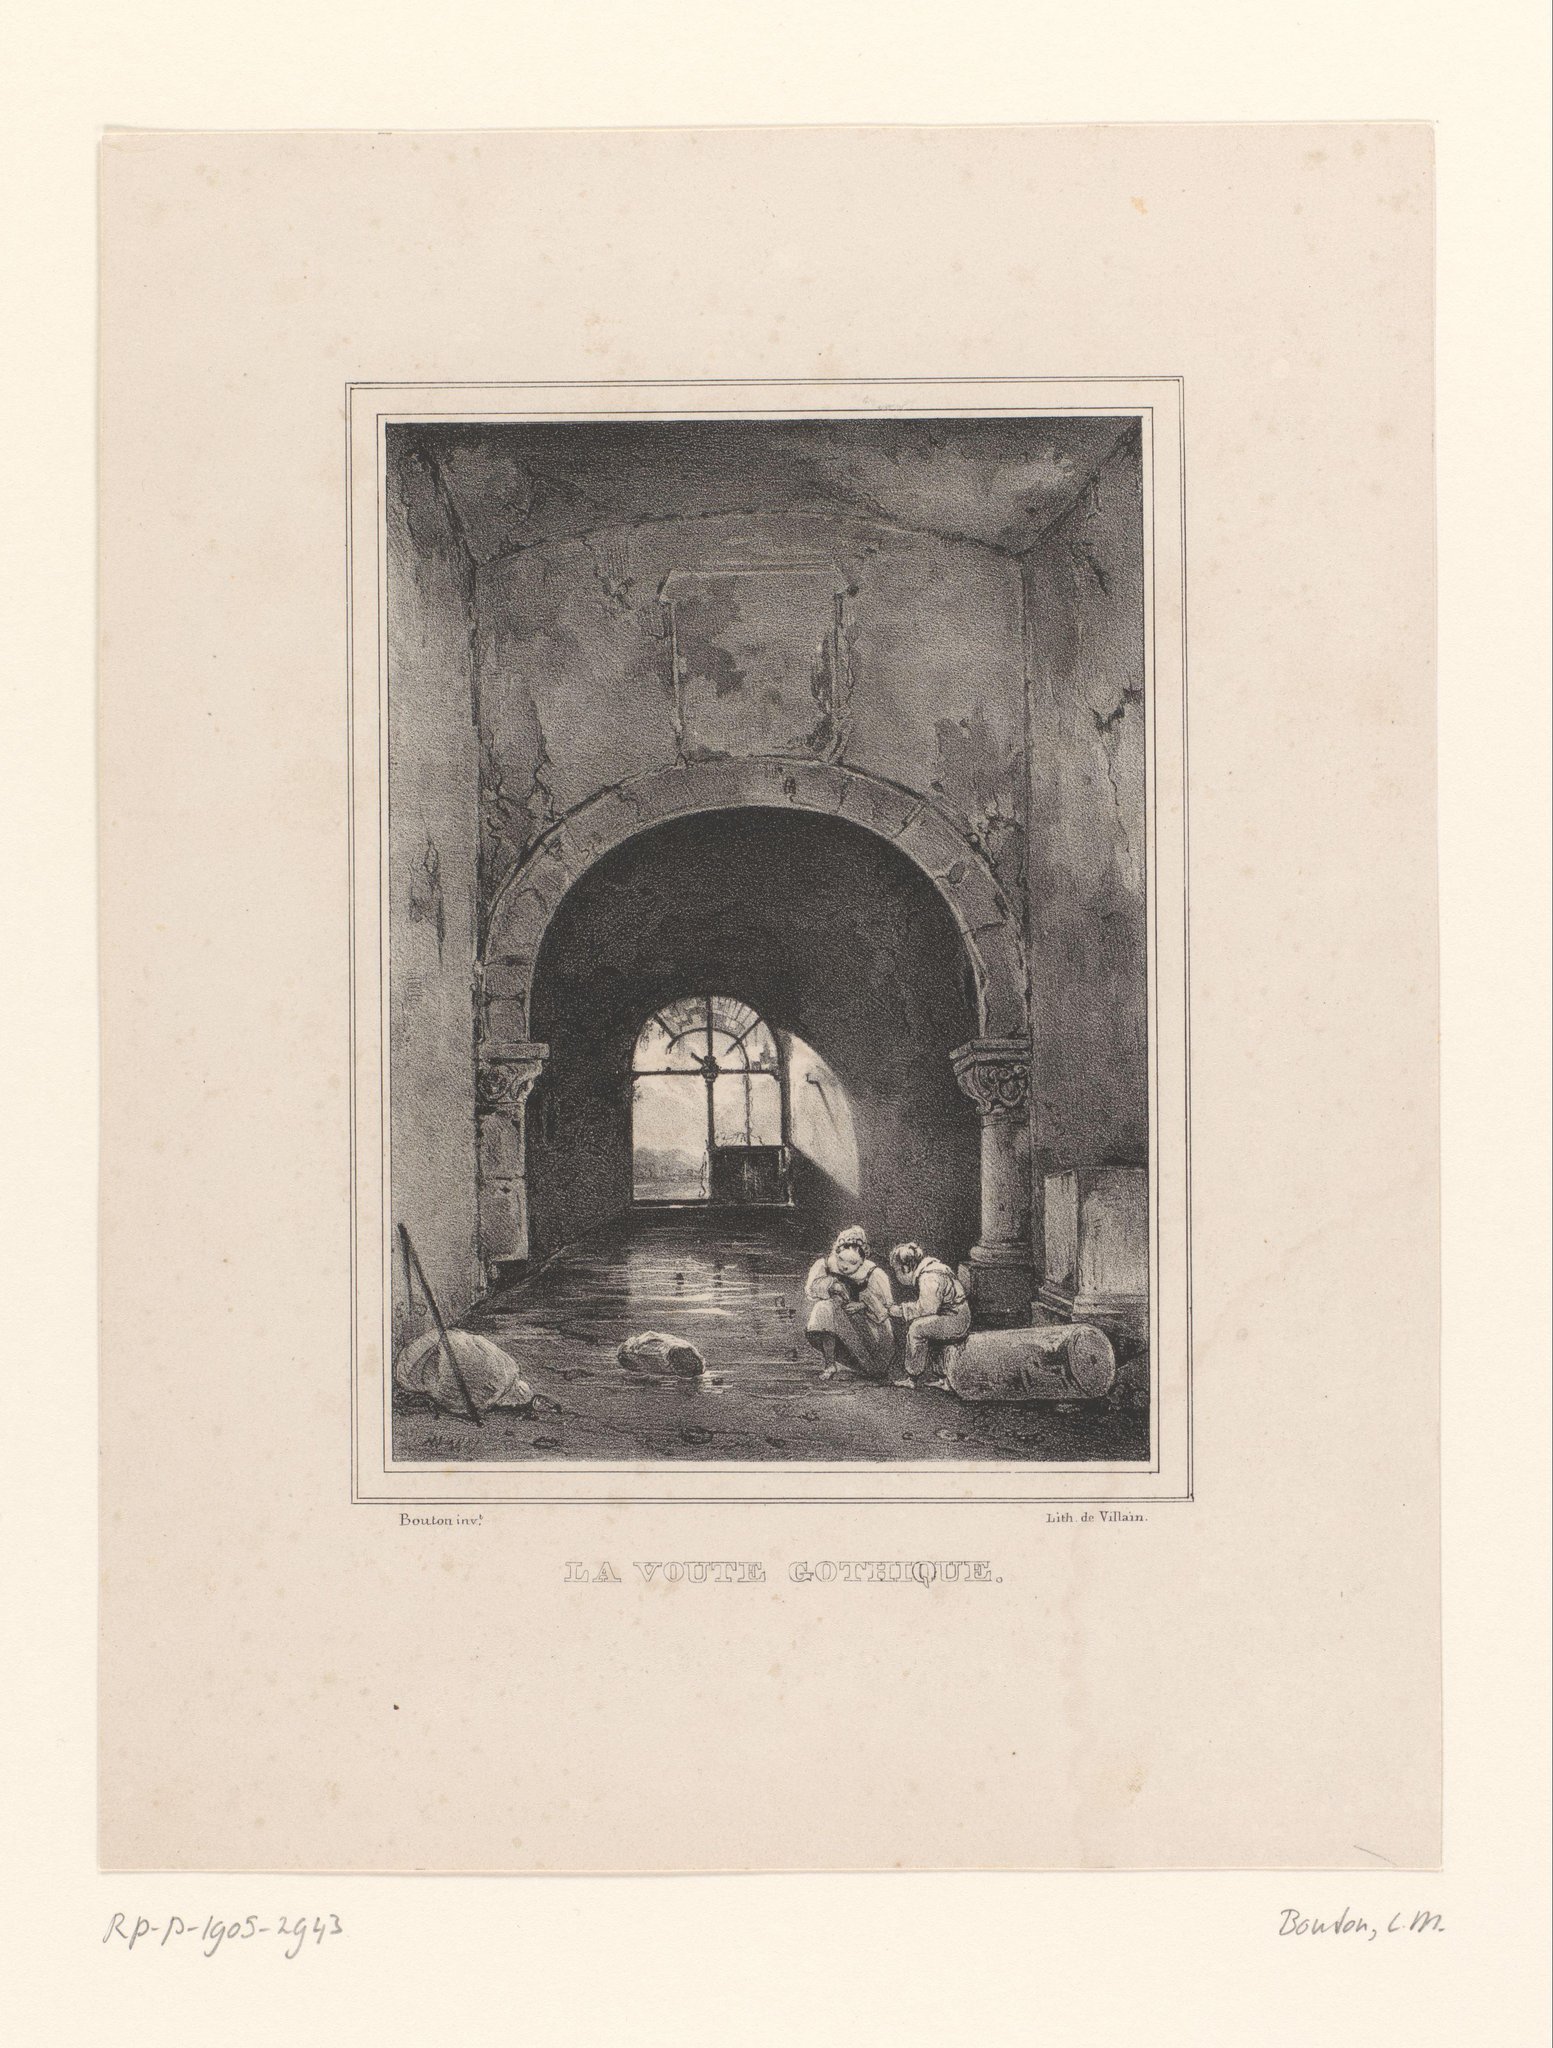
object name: print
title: Twee kinderen onder een gotisch gewelf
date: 1823-1834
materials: paper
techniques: lithograph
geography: paris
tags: vault ~ architecture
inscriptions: collector's mark: Lugt 2228a